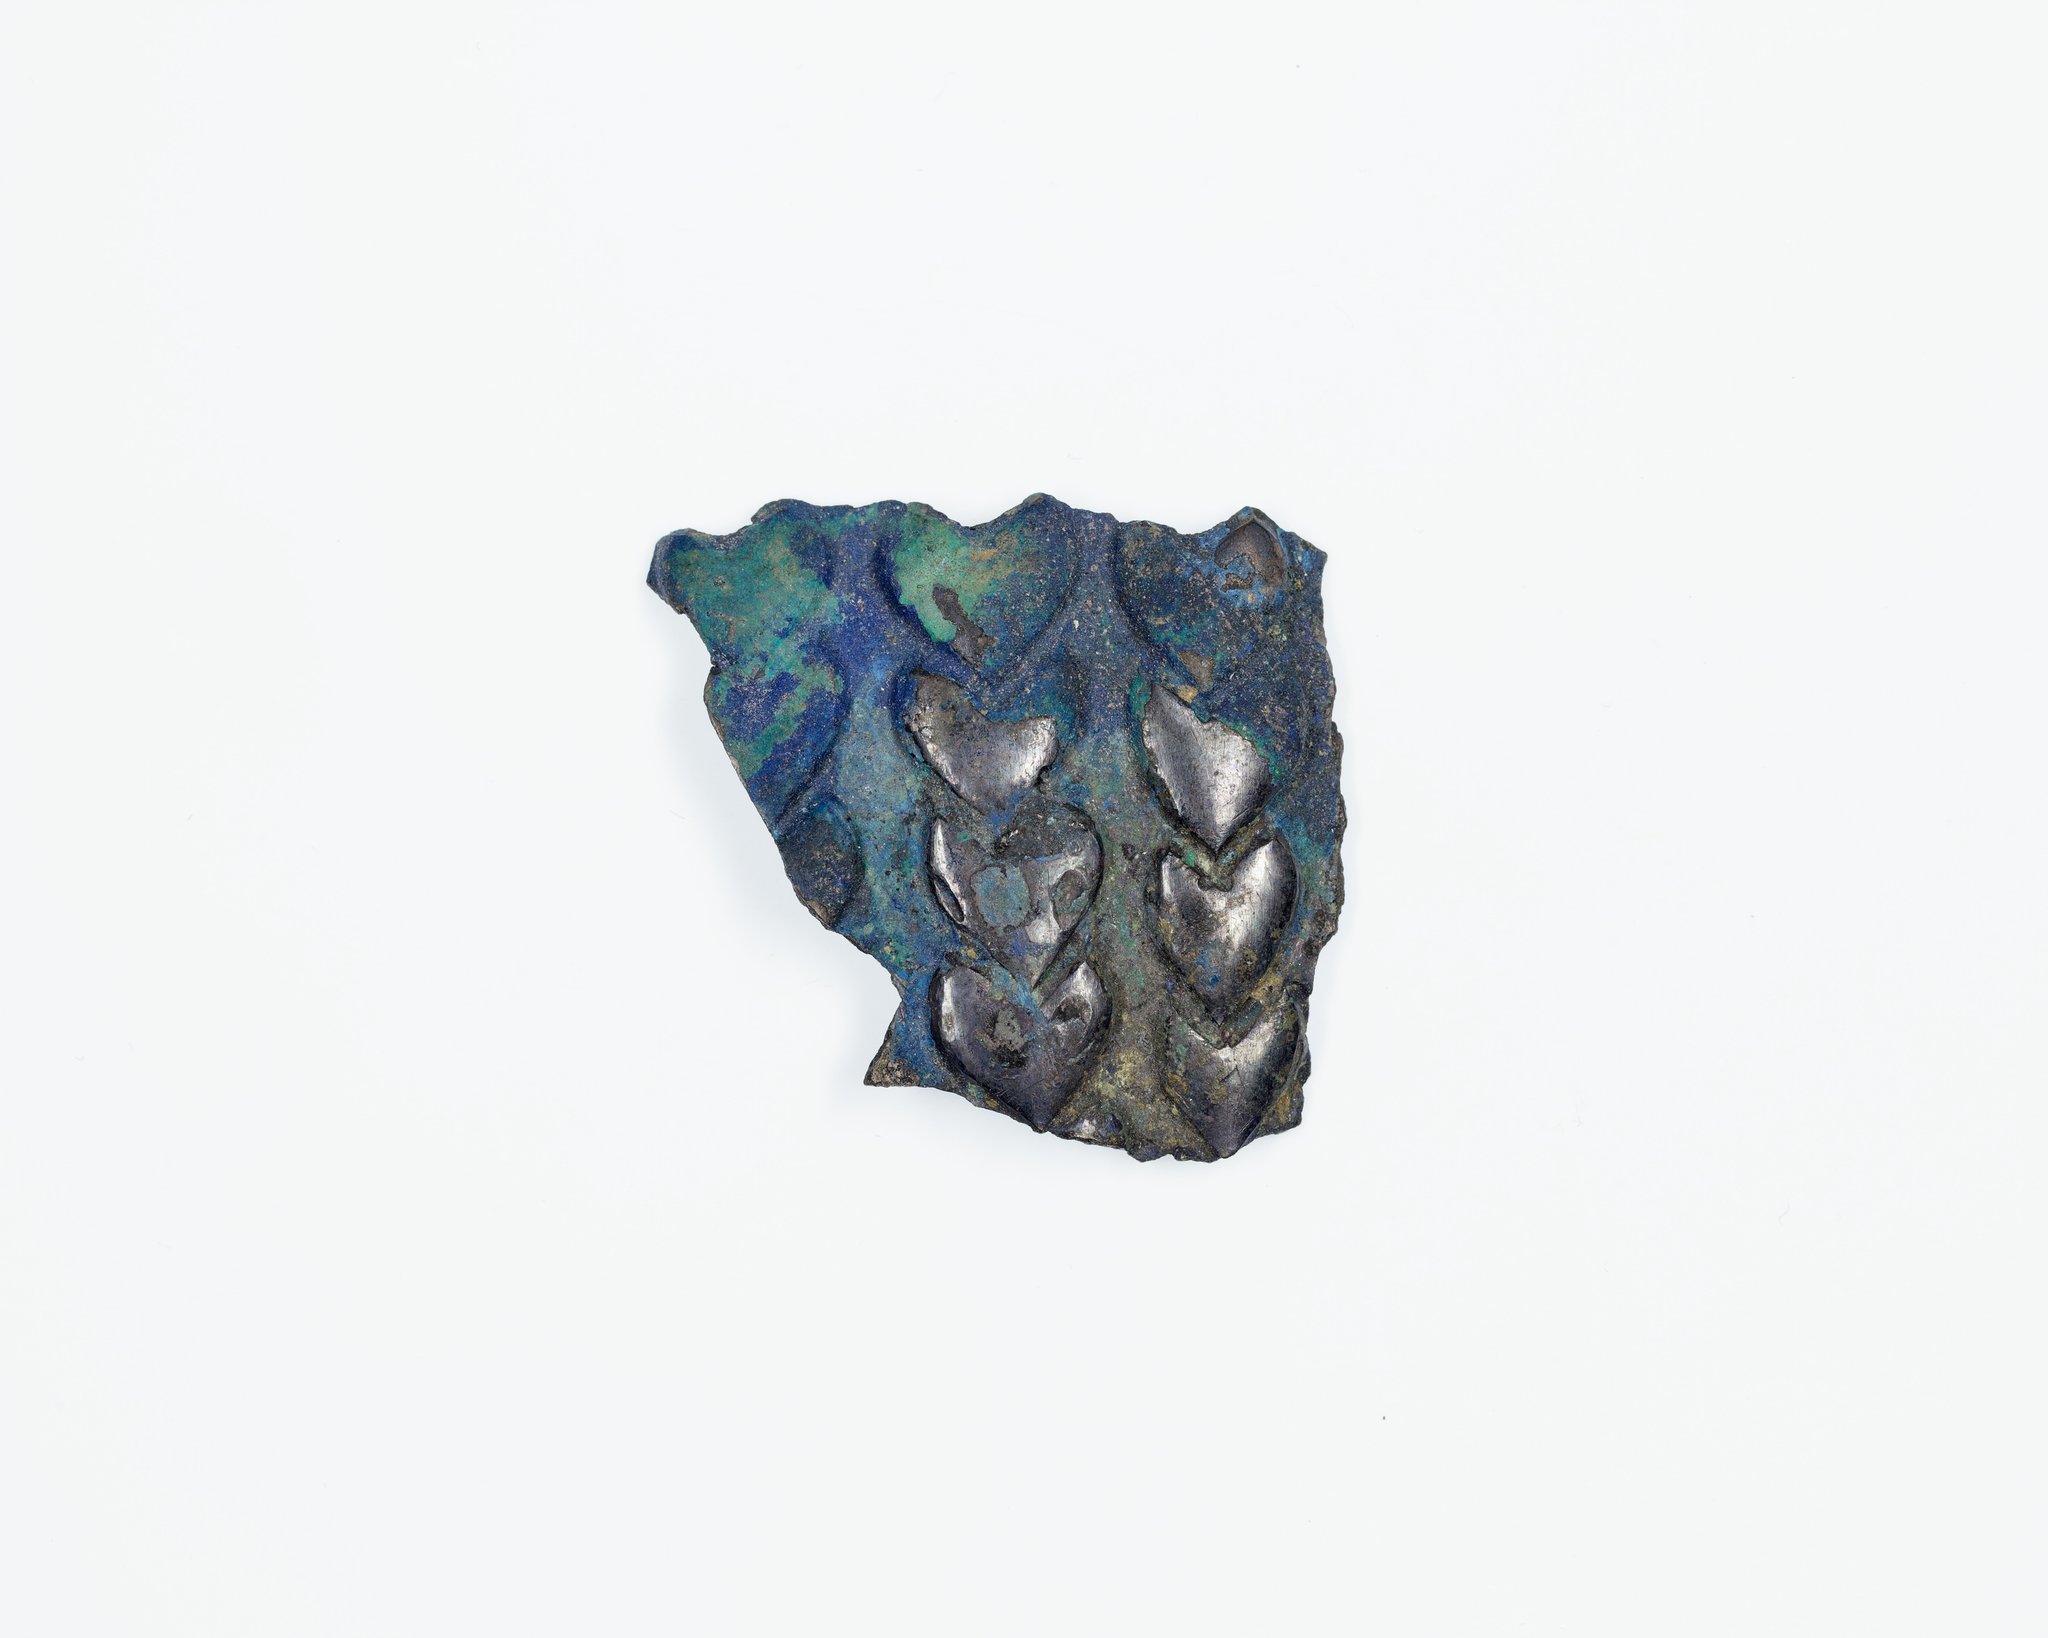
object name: strainer or vase fragment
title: Fragment of a pitcher naming Atumemtaneb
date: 1295-1070 BCE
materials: silver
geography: egypt